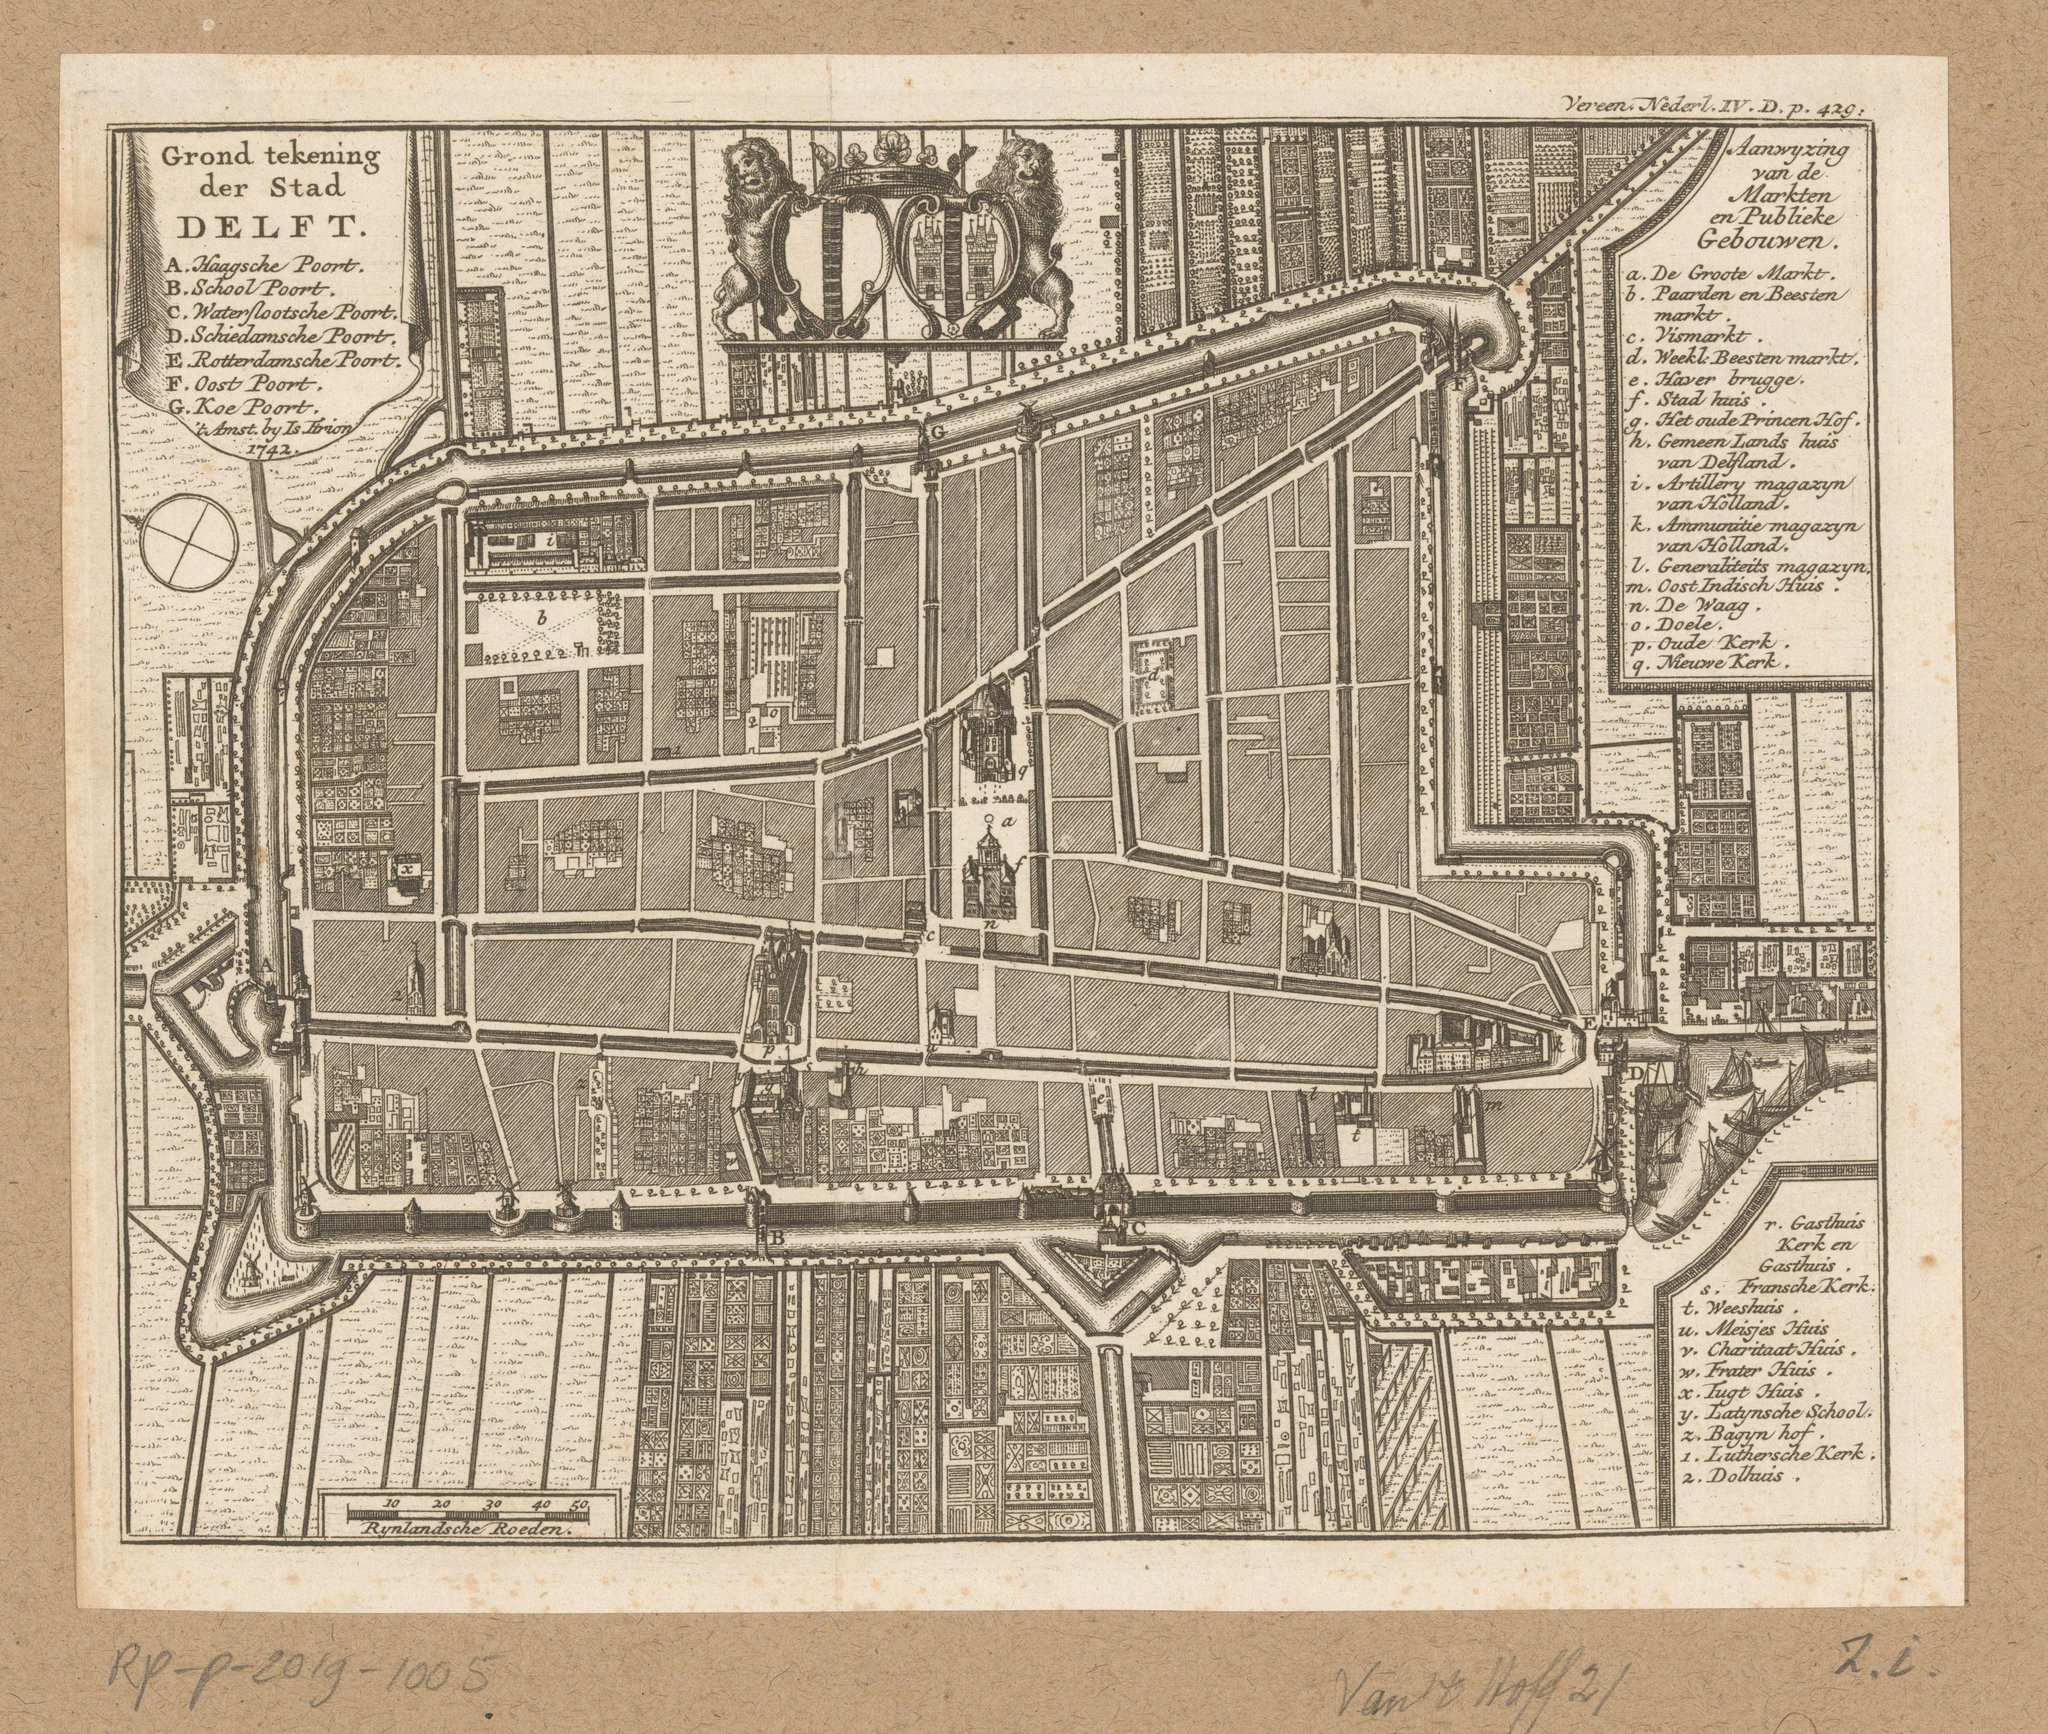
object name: print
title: Grond tekening der Stad Delft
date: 1742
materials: paper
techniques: etching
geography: amsterdam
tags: maps of cities, delft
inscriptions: date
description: Prent uit: Tegenwoordige Staat der Vereenigde Nederlanden (...). Amsterdam: Isaak Tirion, 1742, dl. 4, p. 429.